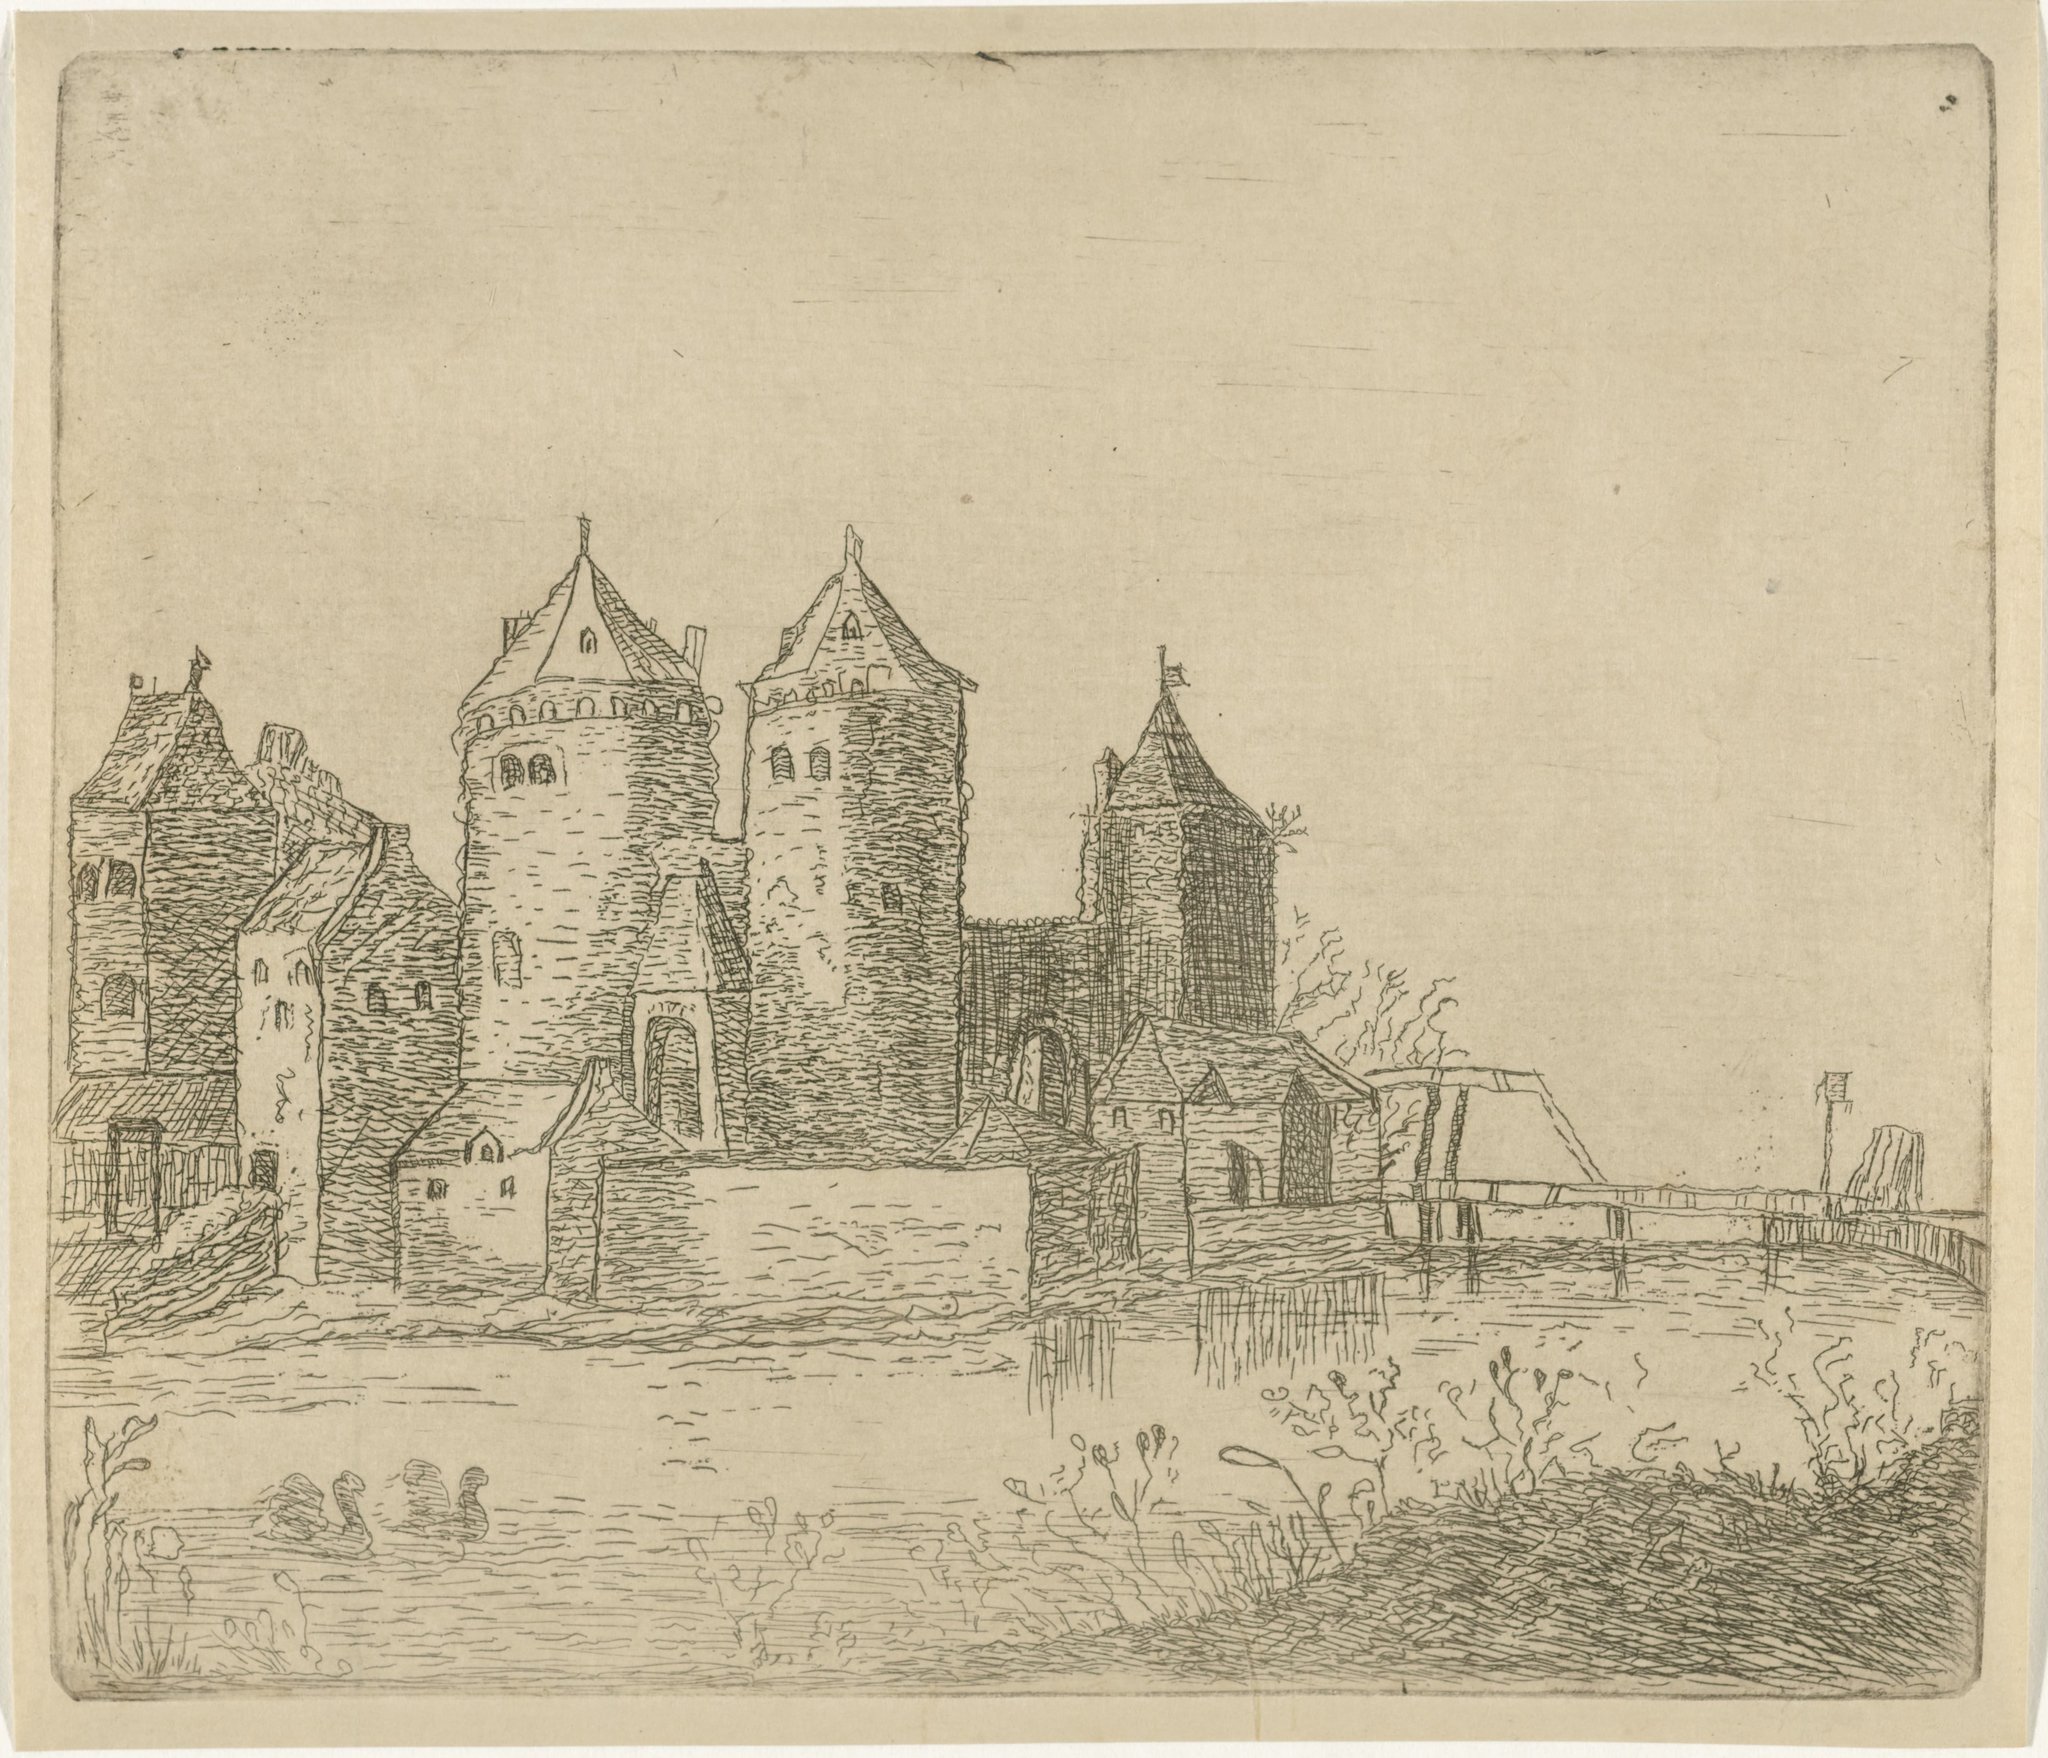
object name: print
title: Gezicht op een kasteel met een slotgracht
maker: christiaan friedrich ruppe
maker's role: print maker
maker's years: 1753-1826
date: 1763-1826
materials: paper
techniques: etching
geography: europe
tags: castle, canal, water-birds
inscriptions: collector's mark: Lugt 2228